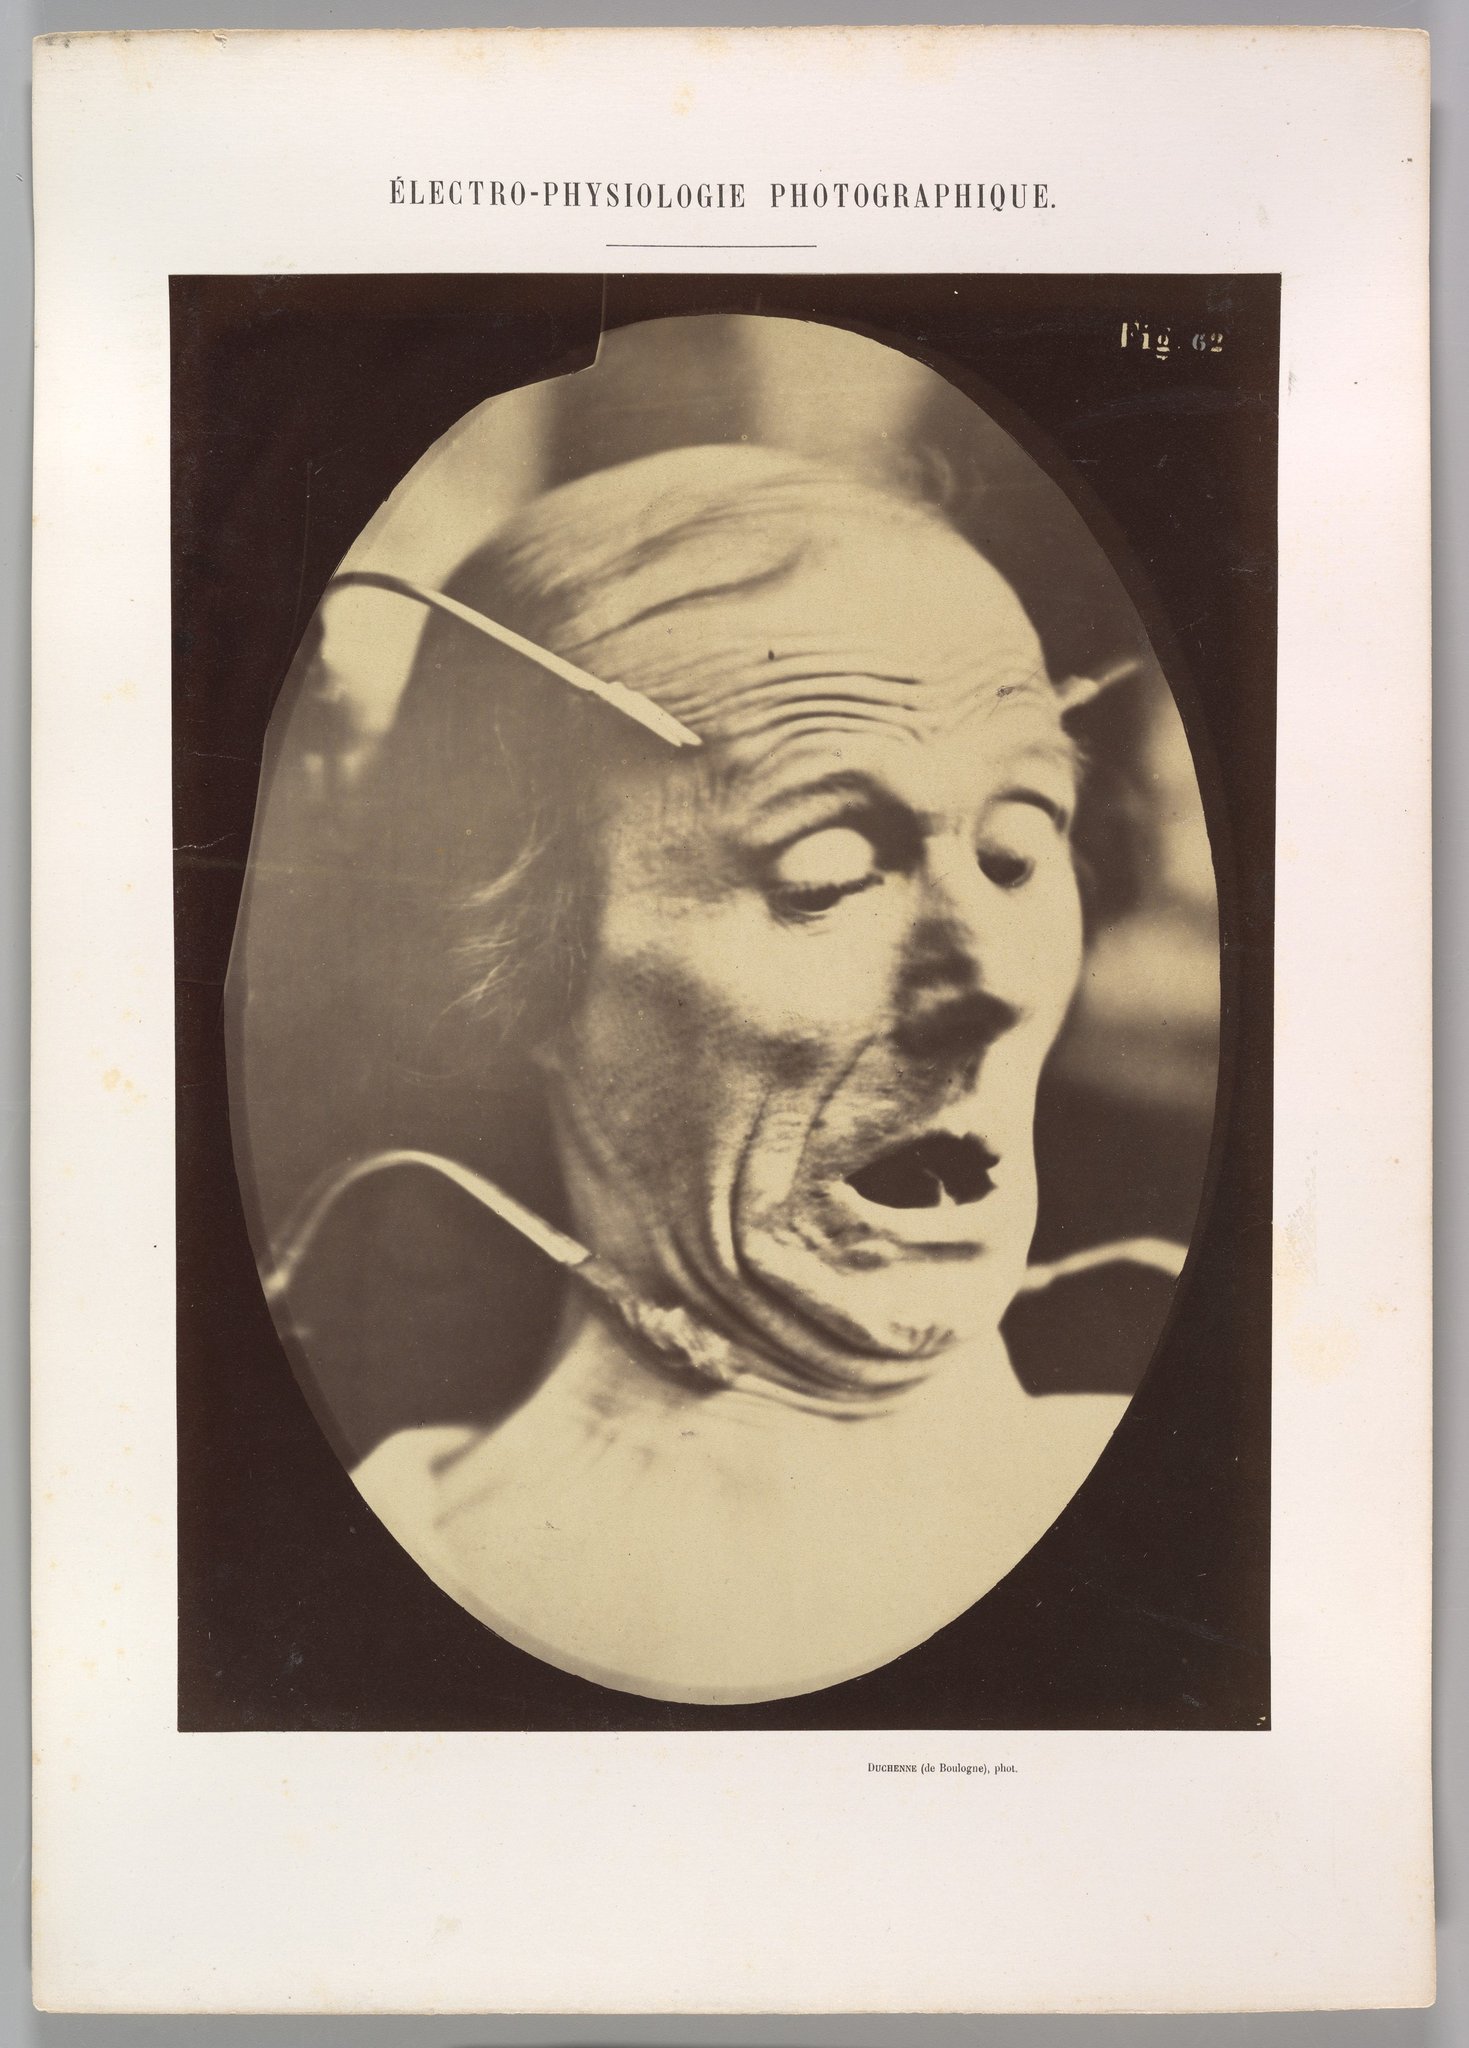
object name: photograph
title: Figure 62: Terror, semiprofile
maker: guillaume-benjamin-amand duchenne de boulogne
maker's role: artist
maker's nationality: french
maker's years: 1806-1875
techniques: albumen silver print, glass negative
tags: fear,men,portraits